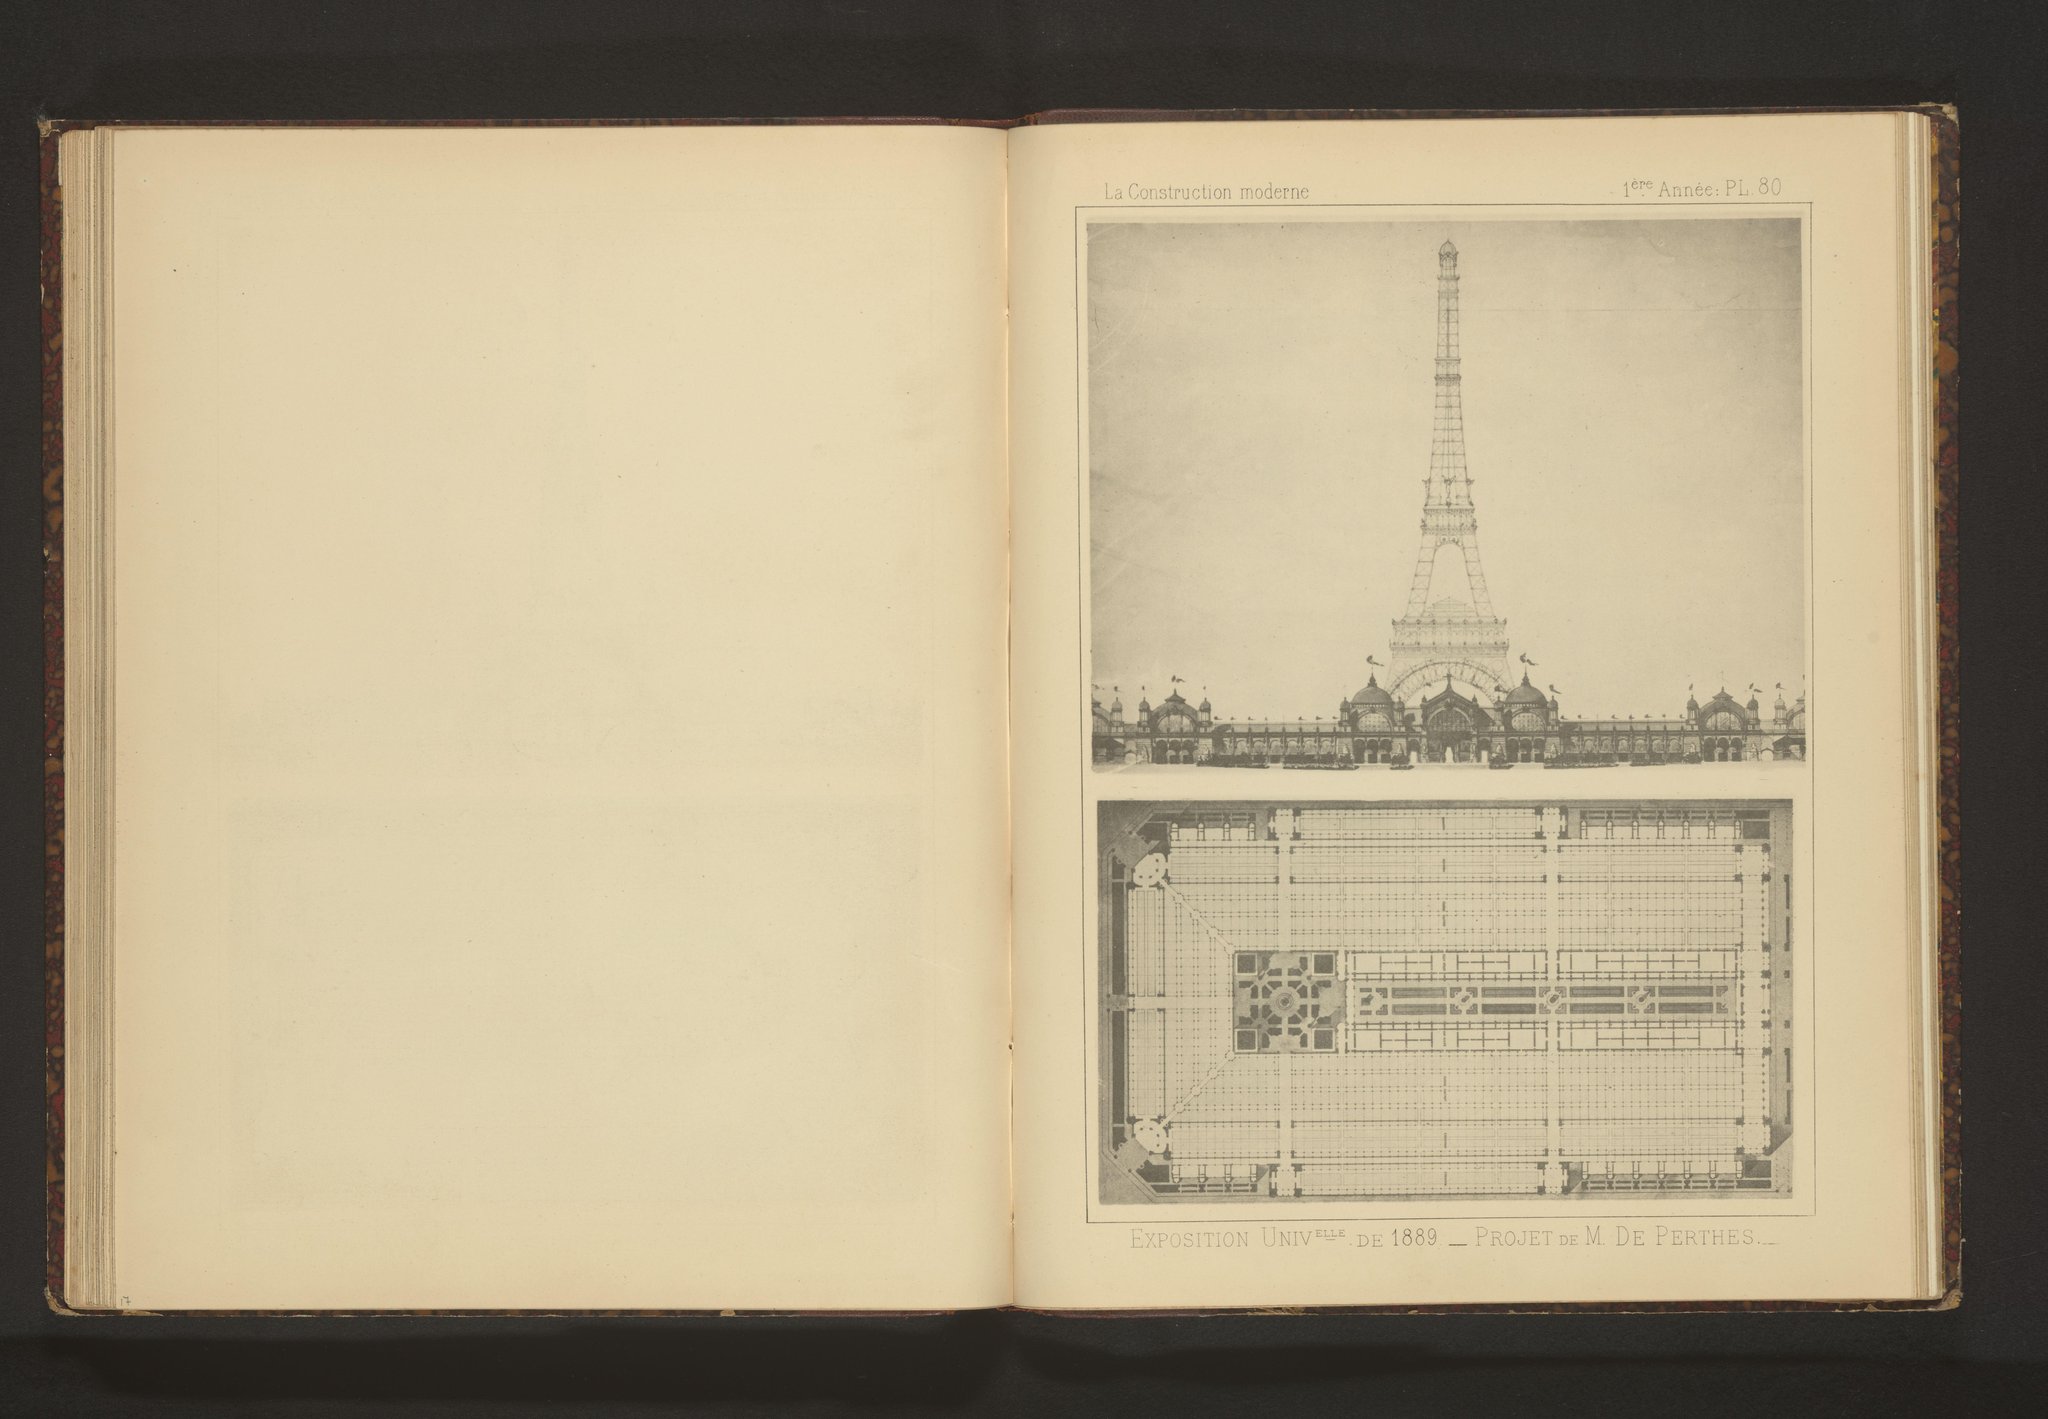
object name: reproduction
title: Exposition Univelle de 1889, Projet de M. De Perthes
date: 1881-1886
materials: paper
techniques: photograph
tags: world fair, world exhibition, maps of cities, paris, eiffel tower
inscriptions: inscription: ‘1ère Année: LA CONSTRUCTION MODERNE Pl. 80’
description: Boven een gezicht op de wereldtentoonstelling met de Eiffeltoren, onder een plattegrond van de wereldtentoonstelling.